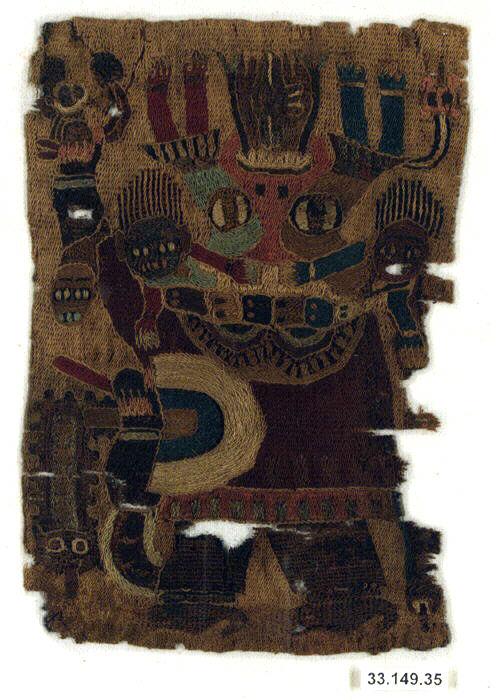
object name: mantle fragment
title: Embroidered Mantle Fragment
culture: paracas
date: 300-101 BCE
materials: animal fiber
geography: peru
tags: heads,serpents